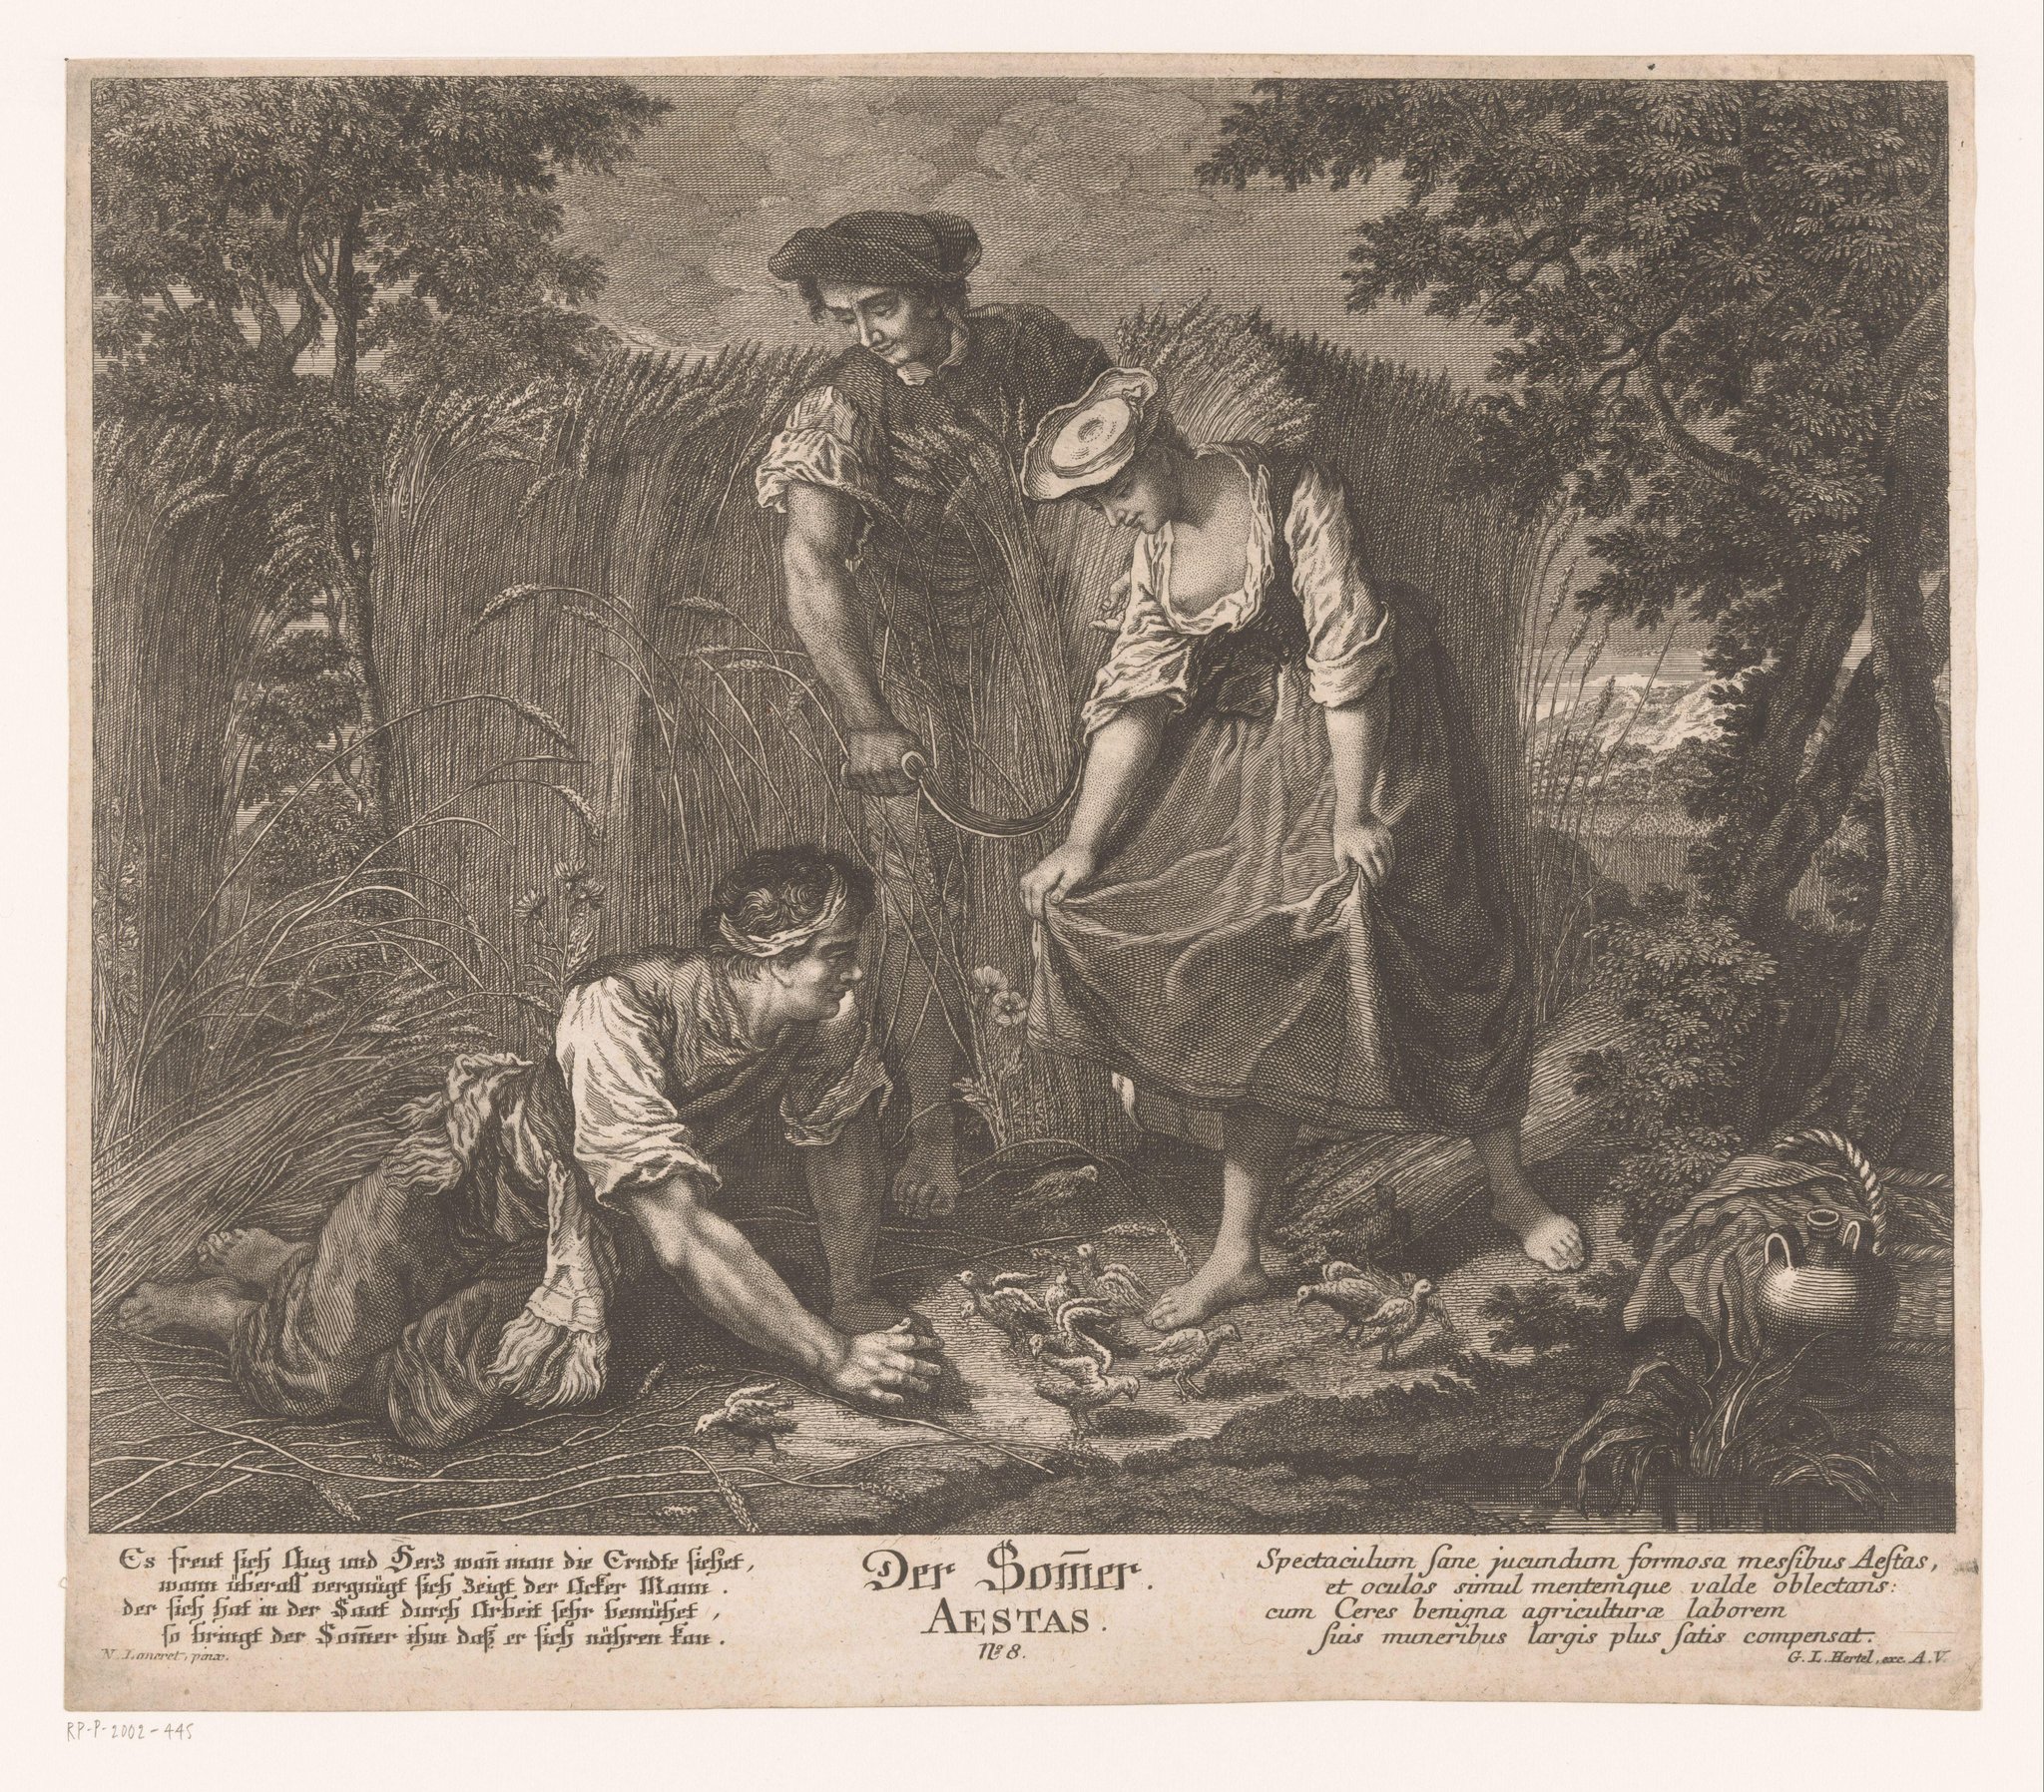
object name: print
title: Zomer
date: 1758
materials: paper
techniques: etching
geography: augsburg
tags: harvest, summer ~ human activities (the four seasons of the year)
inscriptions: collector's mark: Lugt 2228, collector's mark: Lugt 2760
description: Onderdeel van een serie van vier prenten met jonge mensen in de seizoenen.